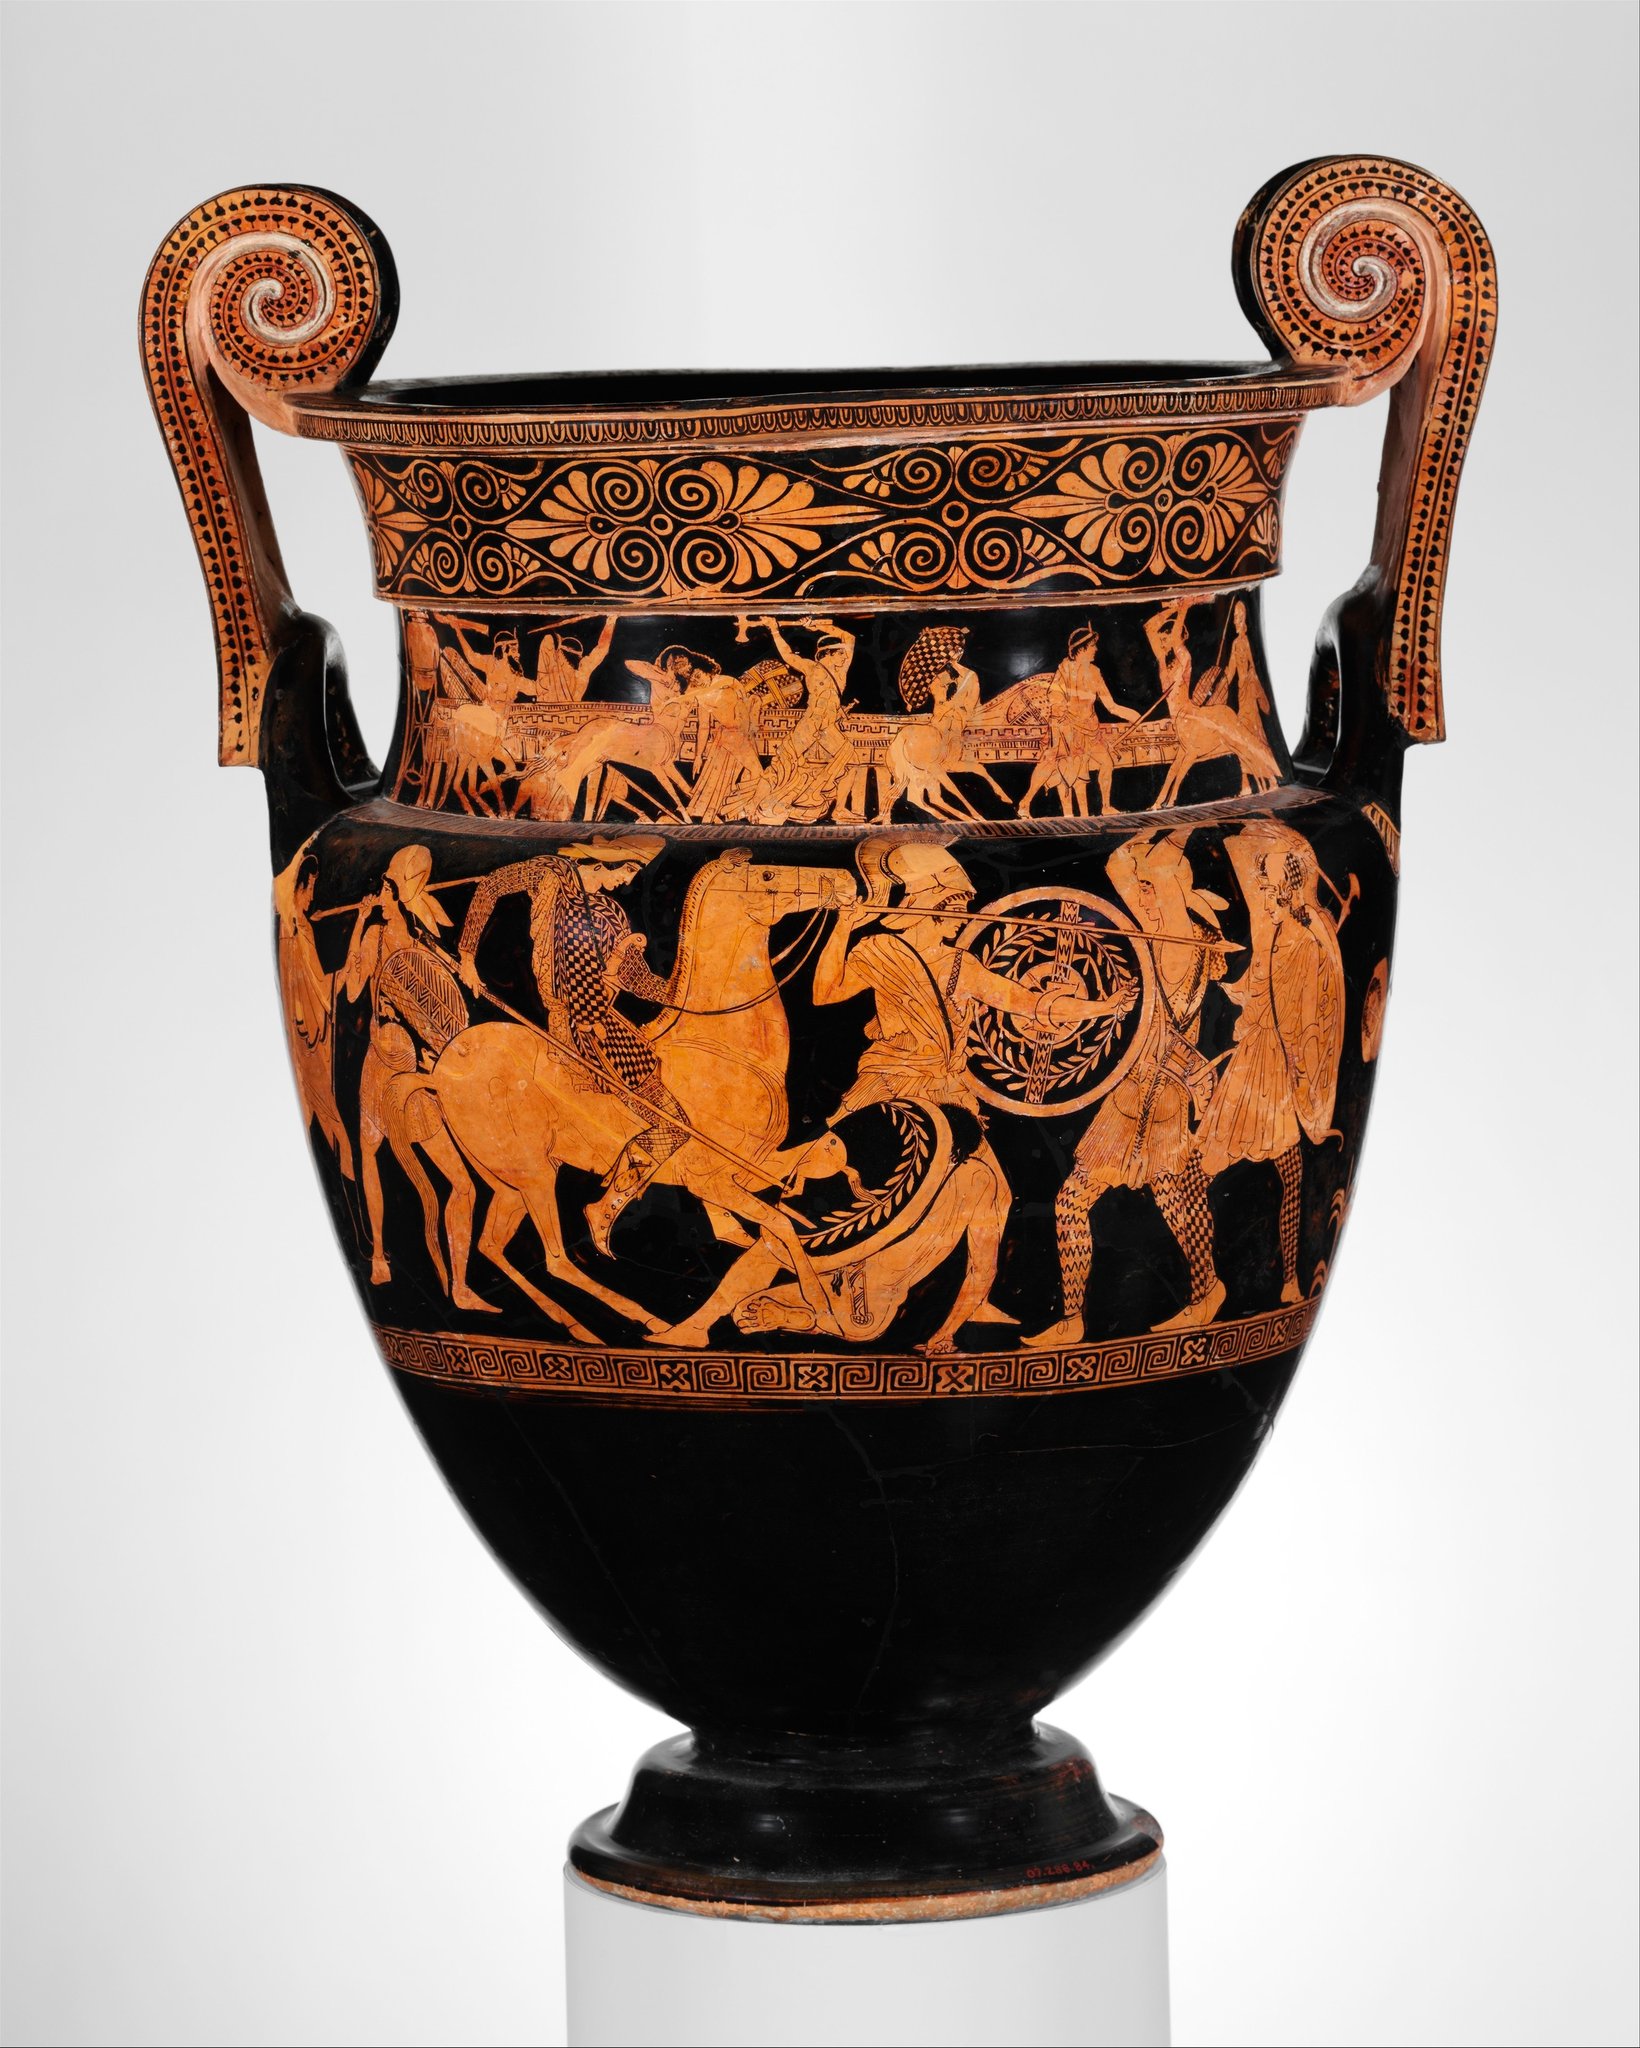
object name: volute krater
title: Terracotta volute-krater (bowl for mixing wine and water)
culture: greek, attic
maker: painter of the woolly satyrs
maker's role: artist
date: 450 BCE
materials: terracotta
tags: battles,women,amazons,centaurs,horses,chariots